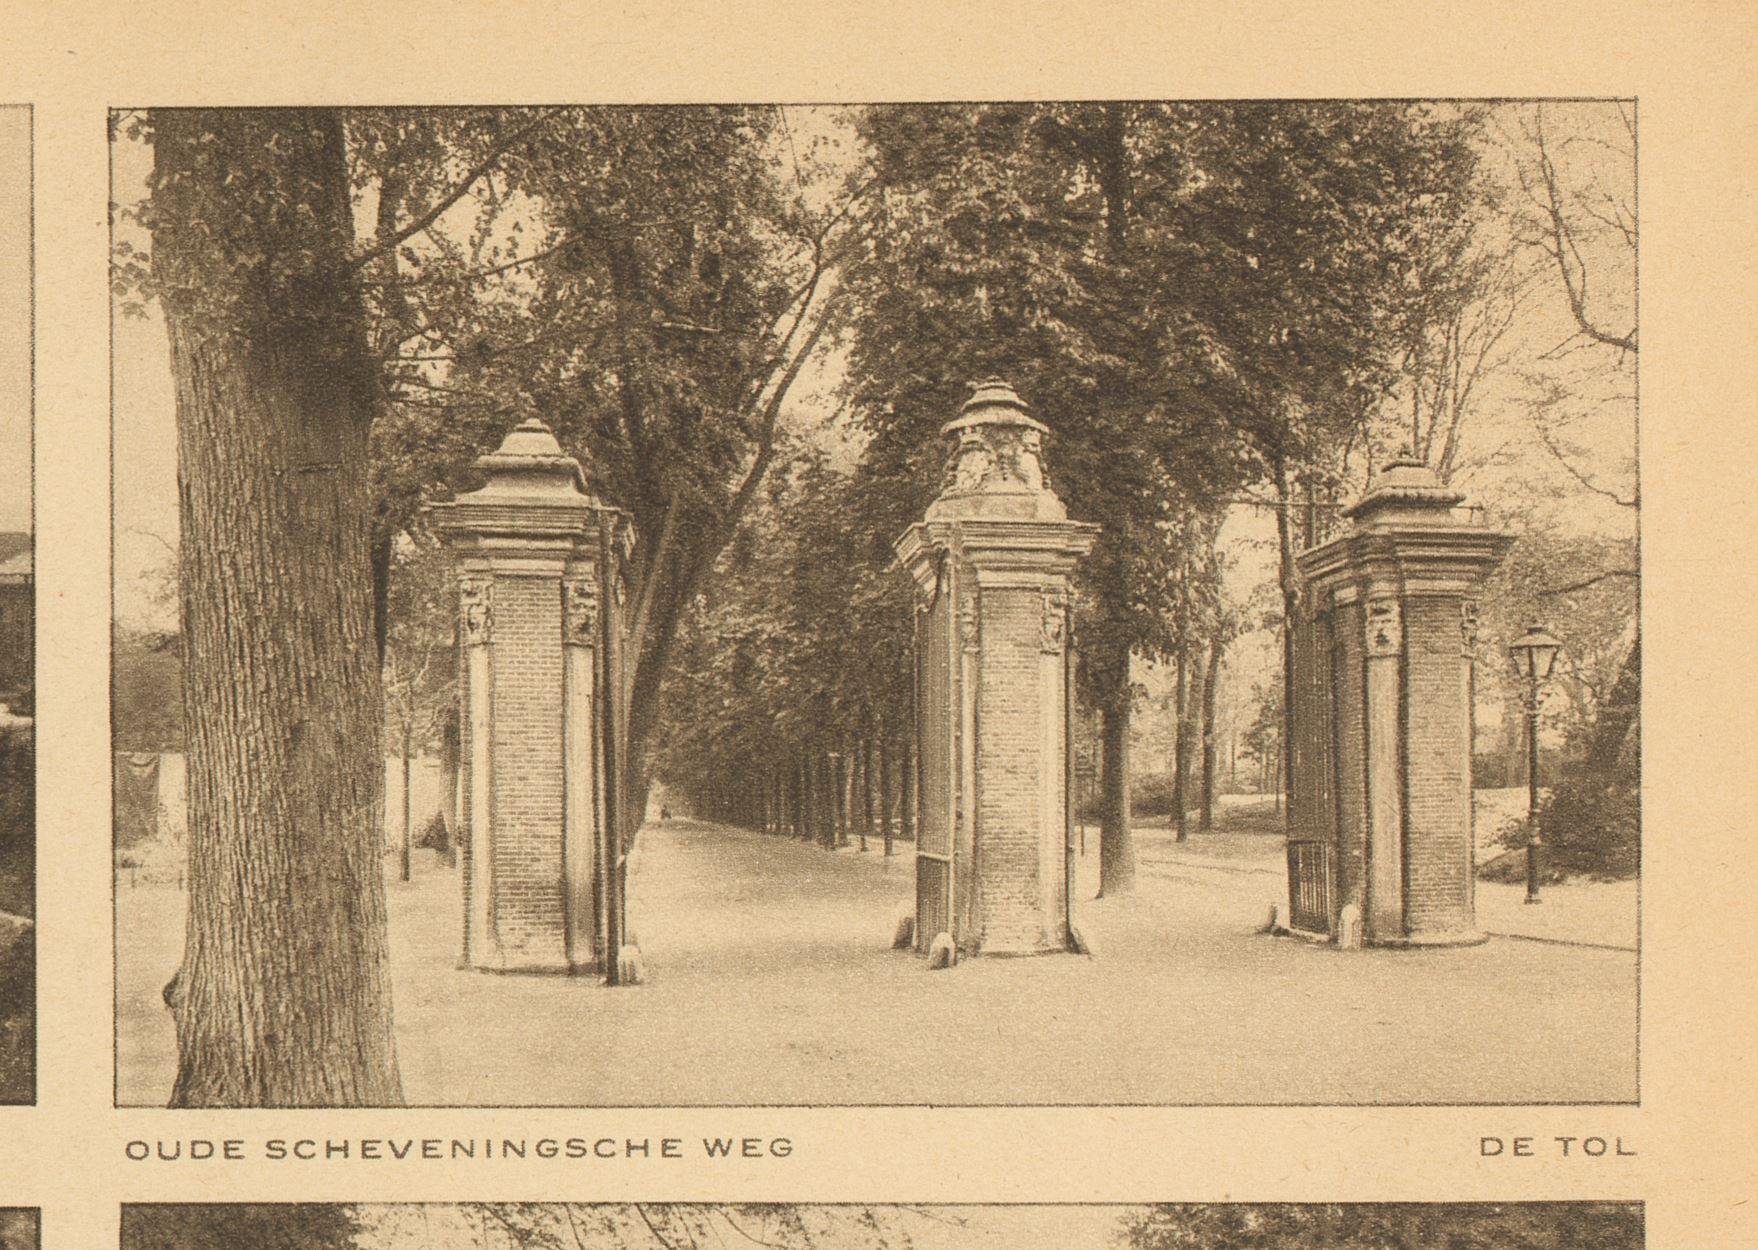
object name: album leaf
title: Gezicht op tolplaats de Huygenspoort aan de Scheveningseweg in Den Haag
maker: Anonymous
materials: paper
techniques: rotogravure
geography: leiden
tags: toll gate, street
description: Deze prent maakt deel uit van een album.